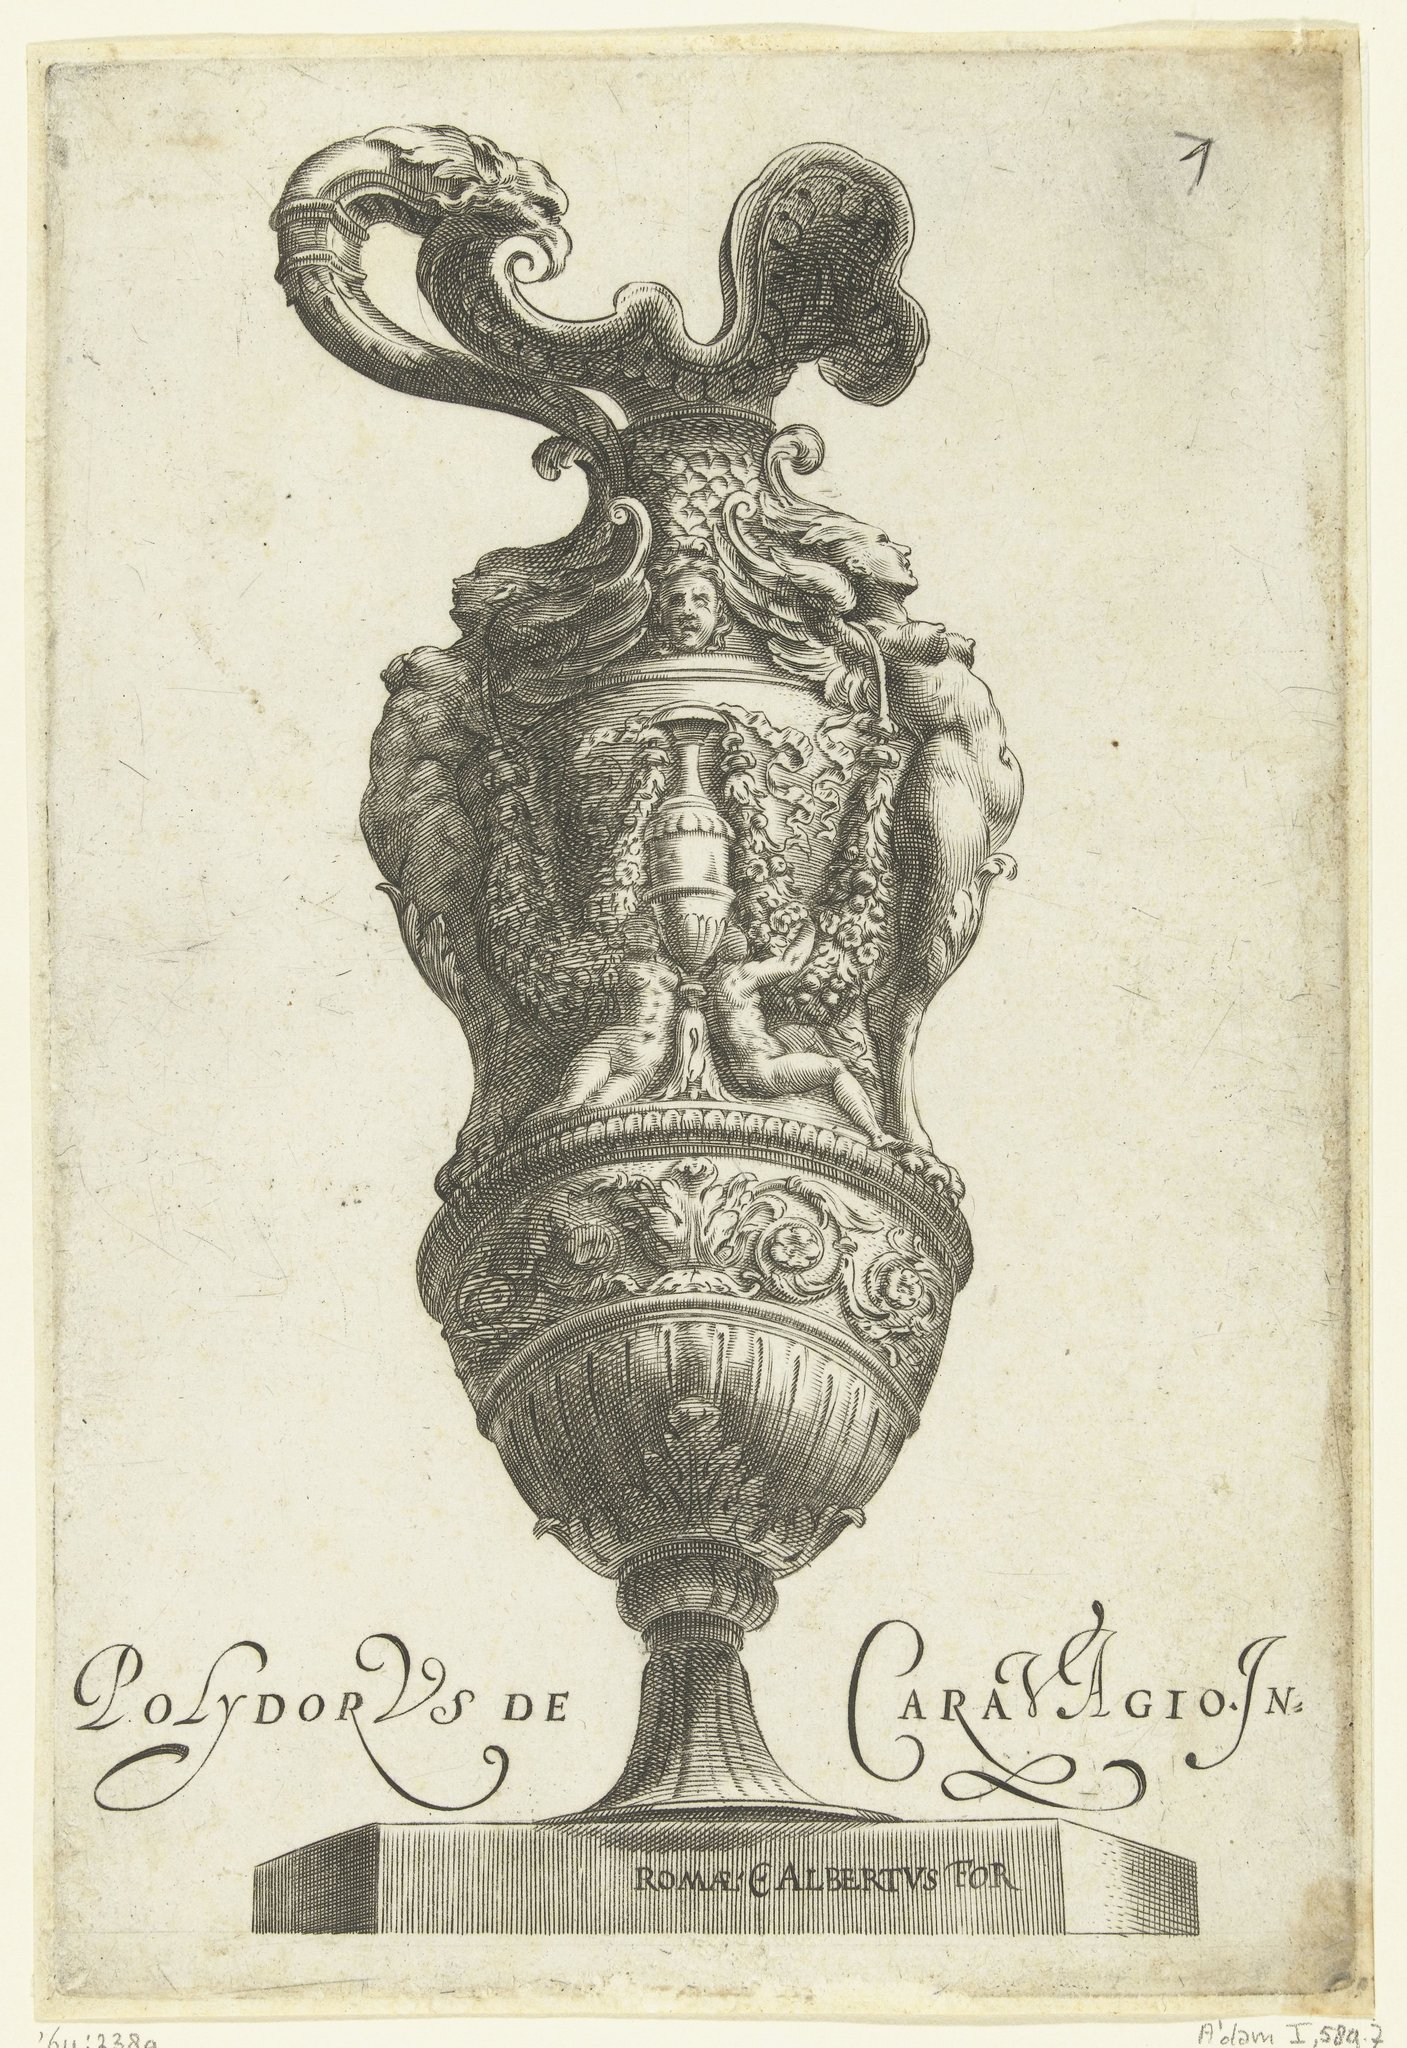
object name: ornament print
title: Kan met een oor, uitlopend in een vogelkop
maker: cherubino alberti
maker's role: draughtsman, print maker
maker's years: 1553-1615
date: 1563-1582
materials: paper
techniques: engraving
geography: italy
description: De buik van de kan is gedecoreerd met twee gevleugelde vrouwelijke saters. Uit serie van 10 bladen. Eerste editie van de serie vazen, die voor de tweede keer in 1628 uitgegeven werd.